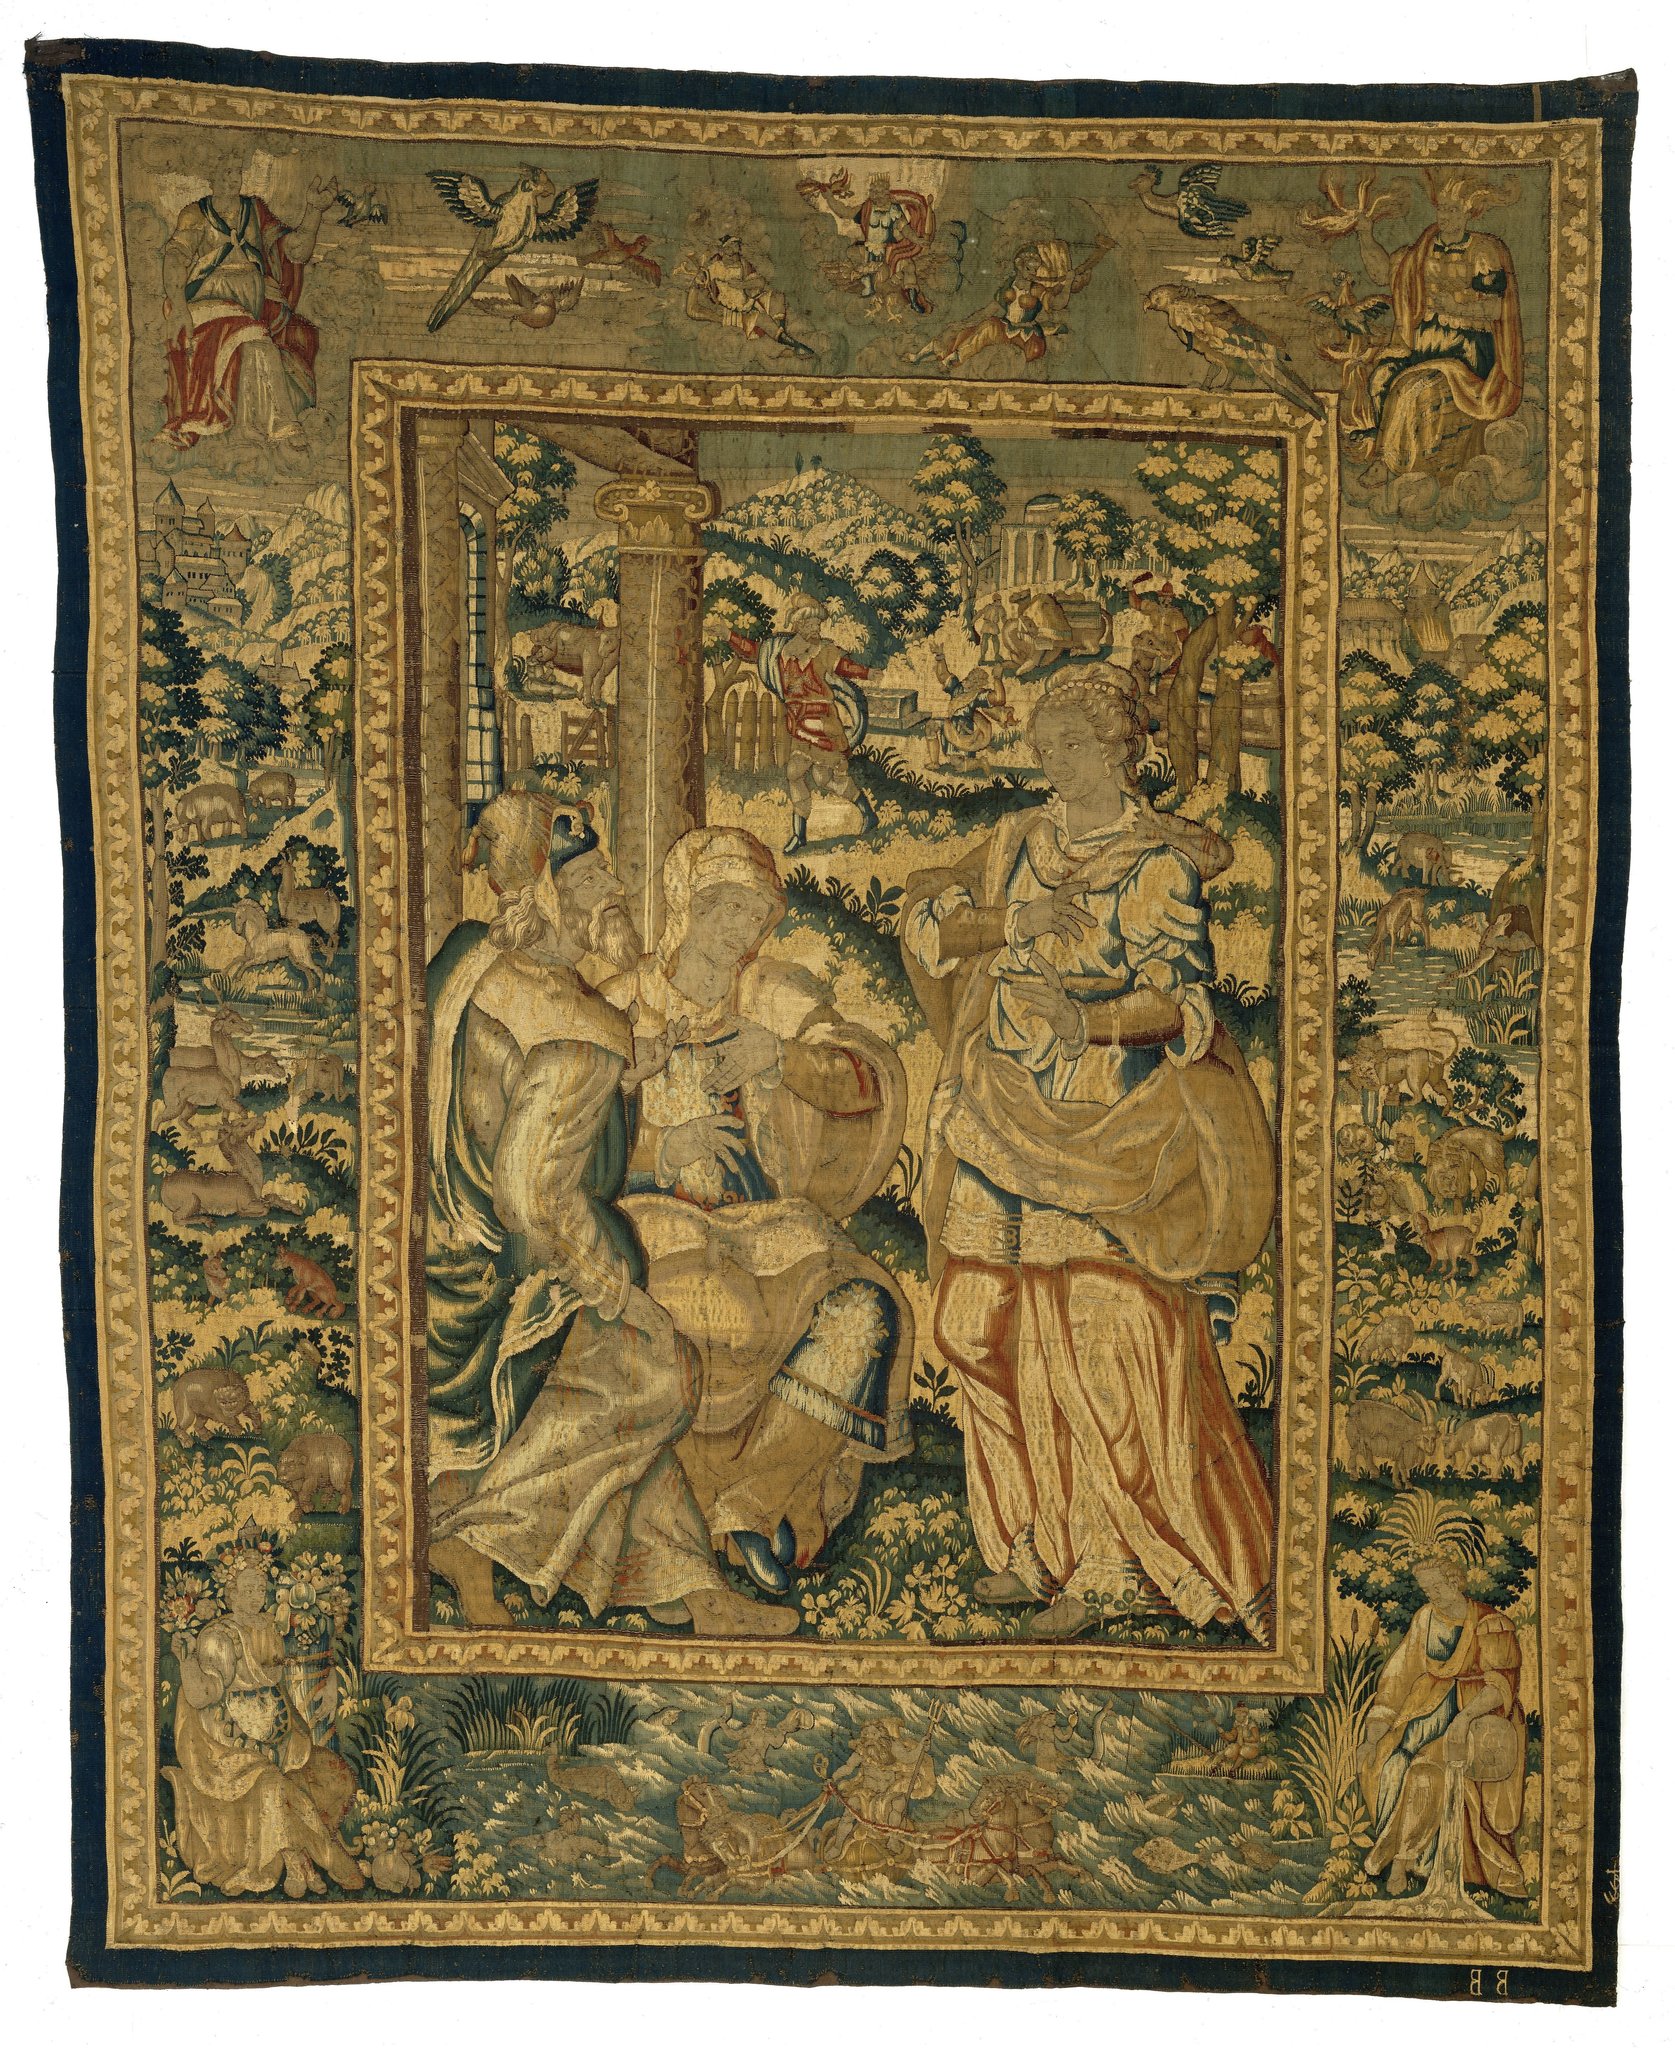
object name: tapestry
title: Rebekka en Eliëzer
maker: Anonymous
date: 1575-1600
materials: silk, wool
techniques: tapestry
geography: brussels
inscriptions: town mark: ‘BB’, weaver's mark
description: Links op de voorgrond zitten laban en Rebekka's moeder voor hun huis. Rechts staat Rebekka. In de achtergrond is Eliëzer tweemaal weergeven.